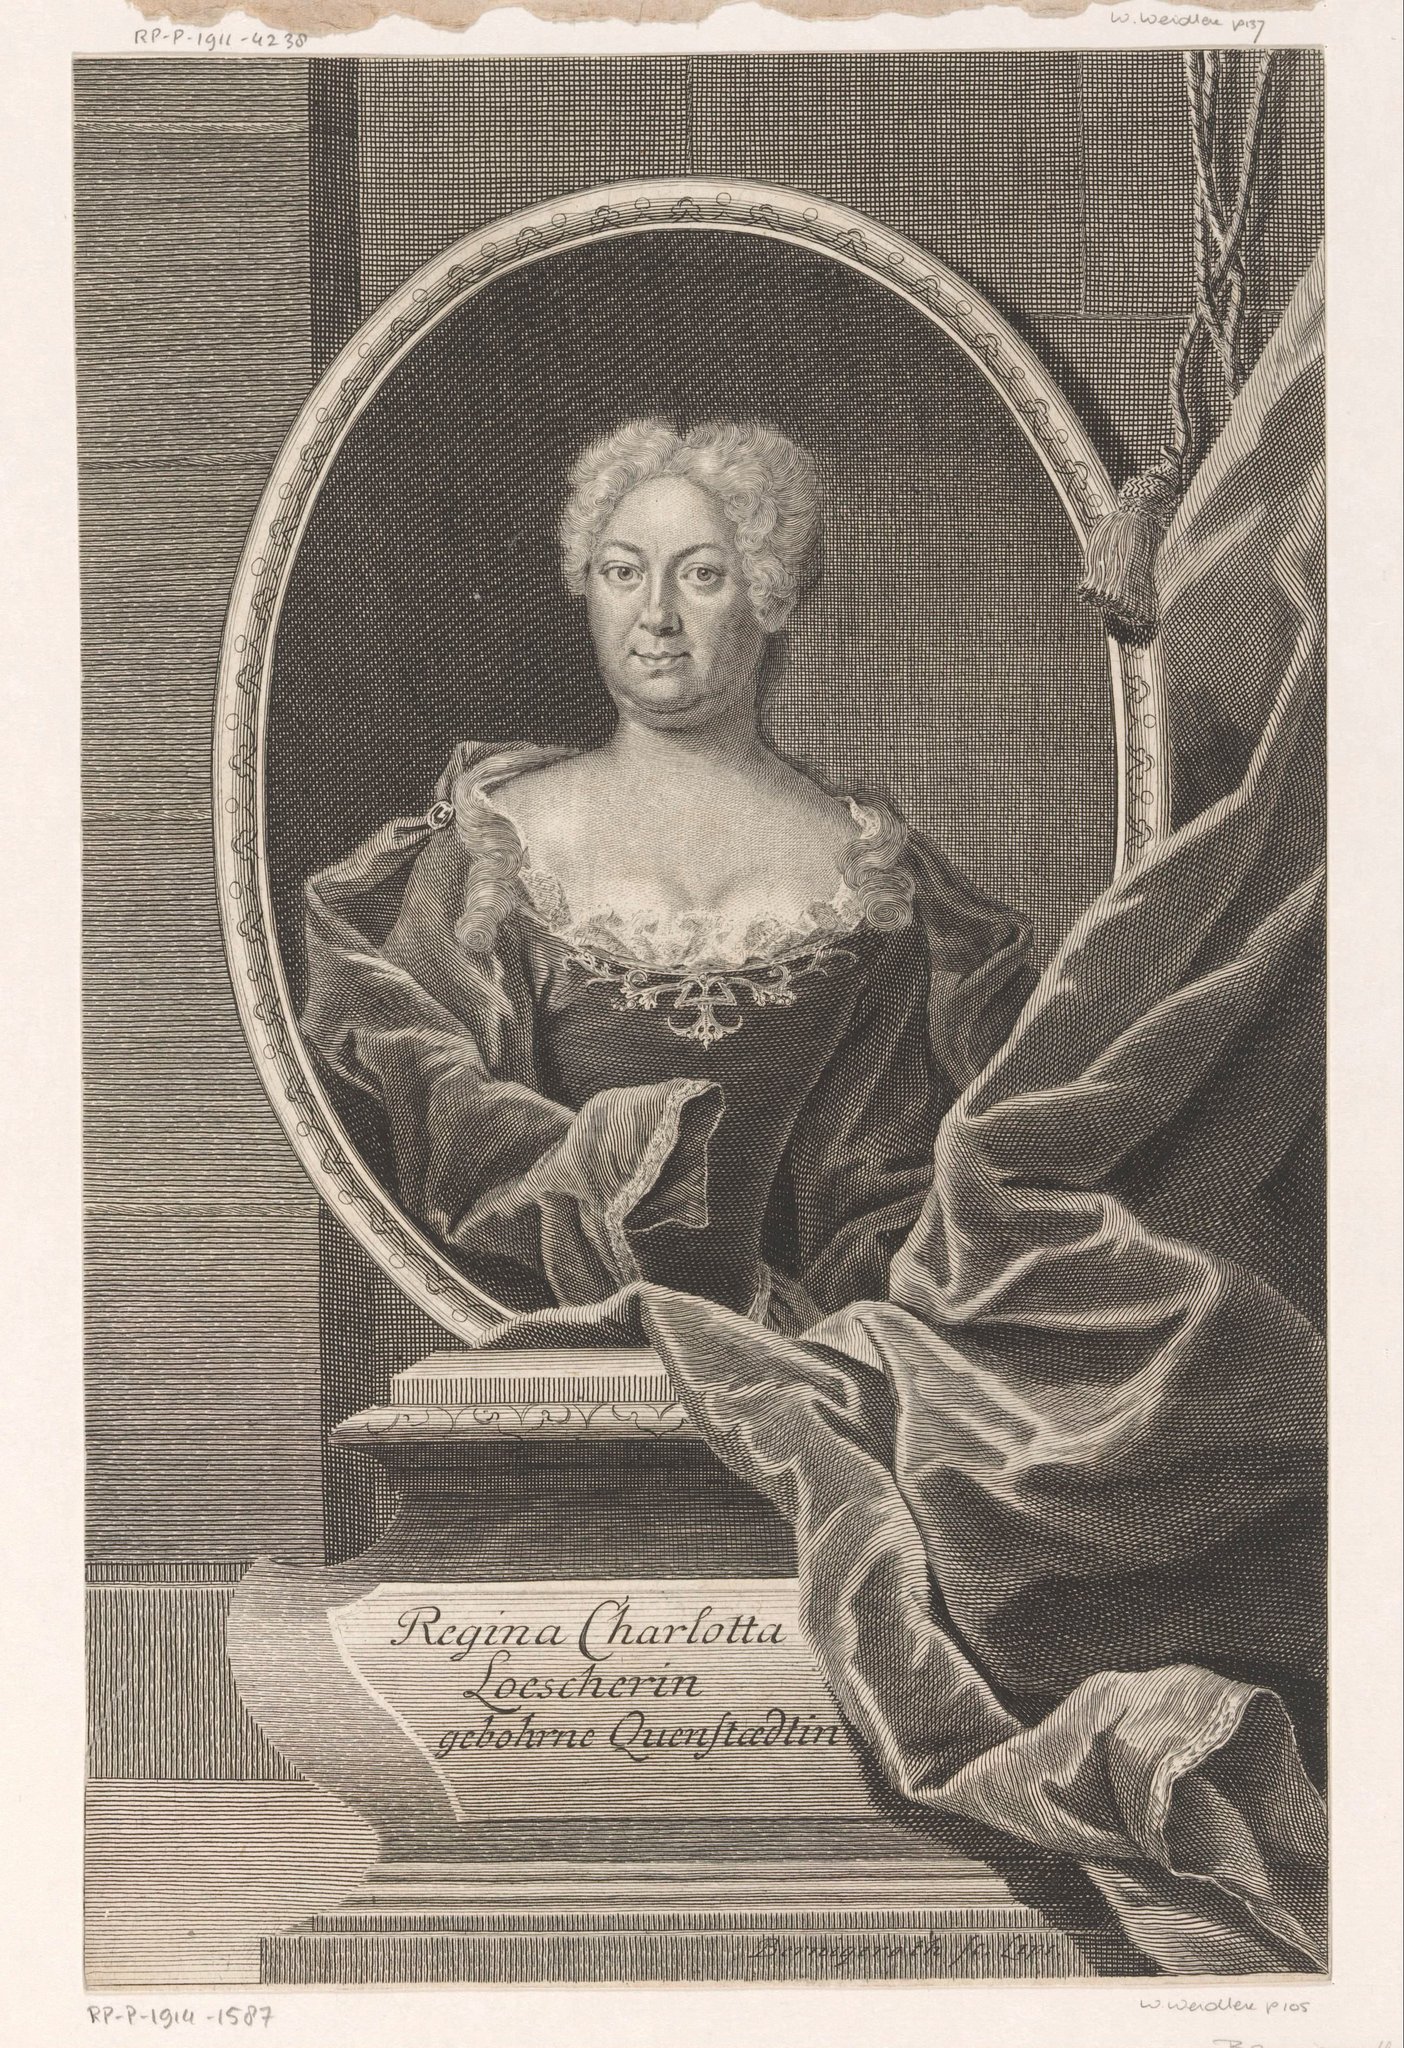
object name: print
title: Portret van Regina Charlotta Loescher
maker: martin bernigeroth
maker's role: print maker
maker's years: 1670-1733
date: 1710-1733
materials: paper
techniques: engraving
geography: leipzig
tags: historical persons - bb - woman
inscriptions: collector's mark: Lugt 2228